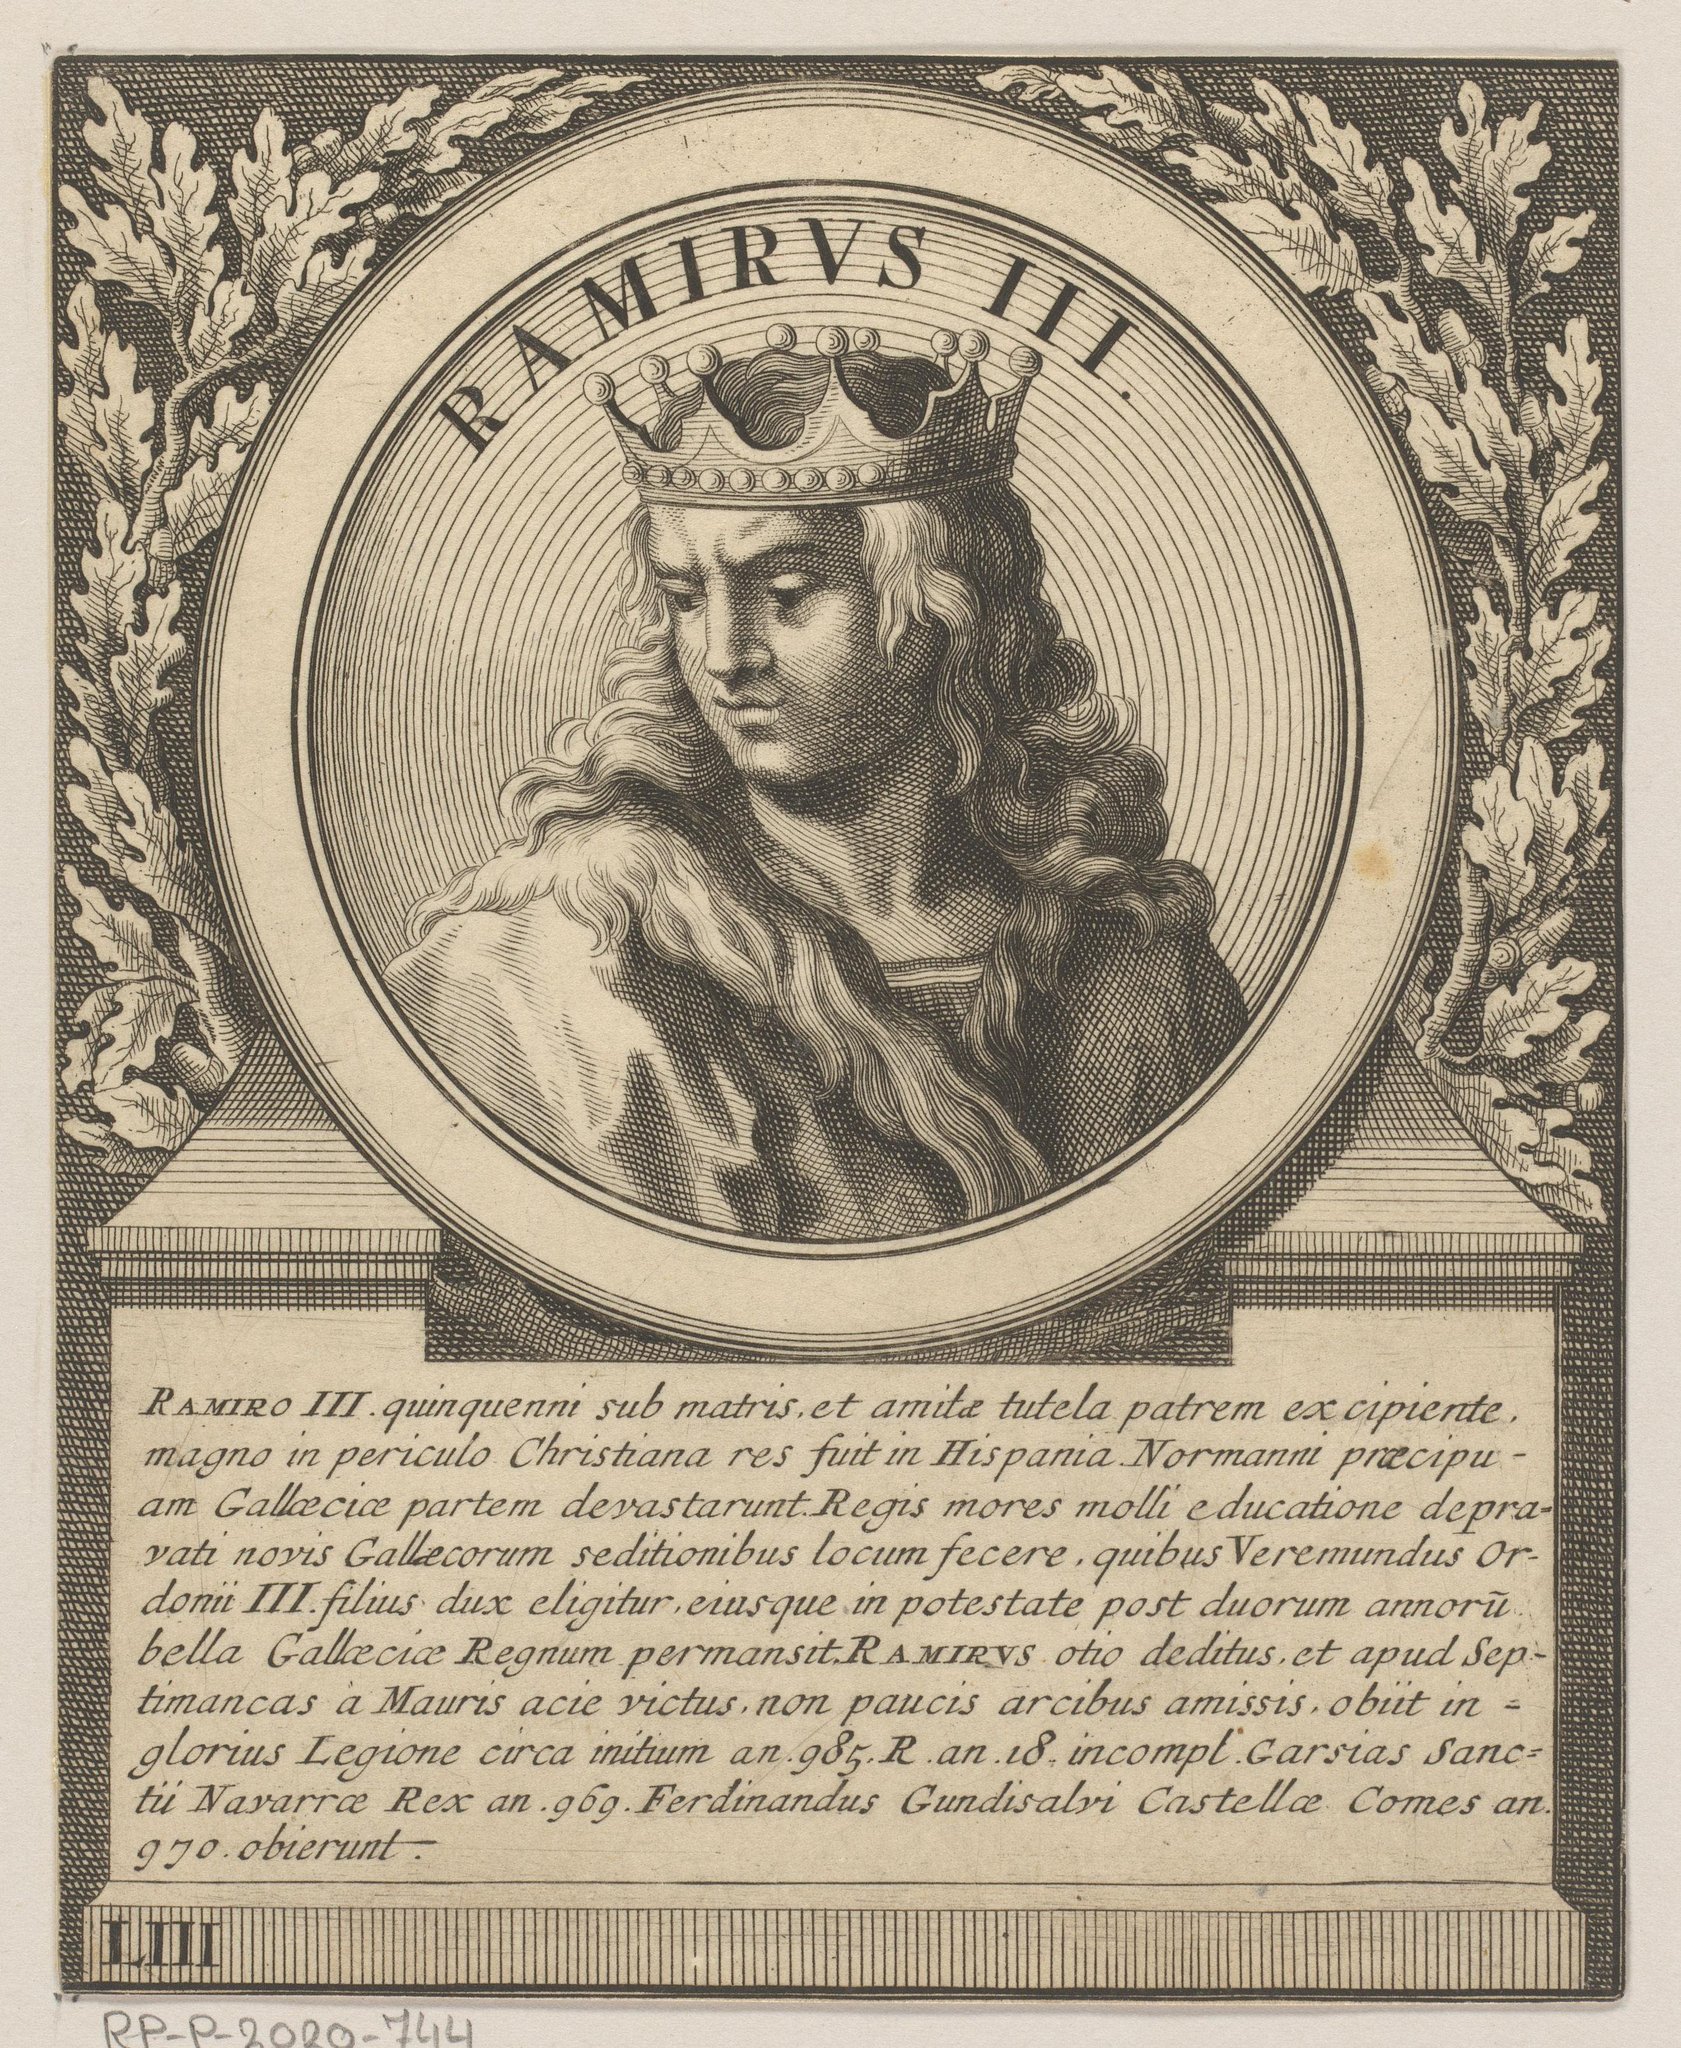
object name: print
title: Series Chronologica et Imagines Regum Hispaniae ab Ataulpho ad Carolum II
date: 1698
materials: paper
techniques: engraving, etching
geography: paris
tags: historical persons, ruler, sovereign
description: Portret afkomstig van een grote prent, getiteld 'Series Chronologica et Imagines Regum Hispaniae ab Ataulpho ad Carolum II', bestaande uit meerdere bladen die samengevoegd konden worden, uitgegeven door Petrus de la Tour in 1698.